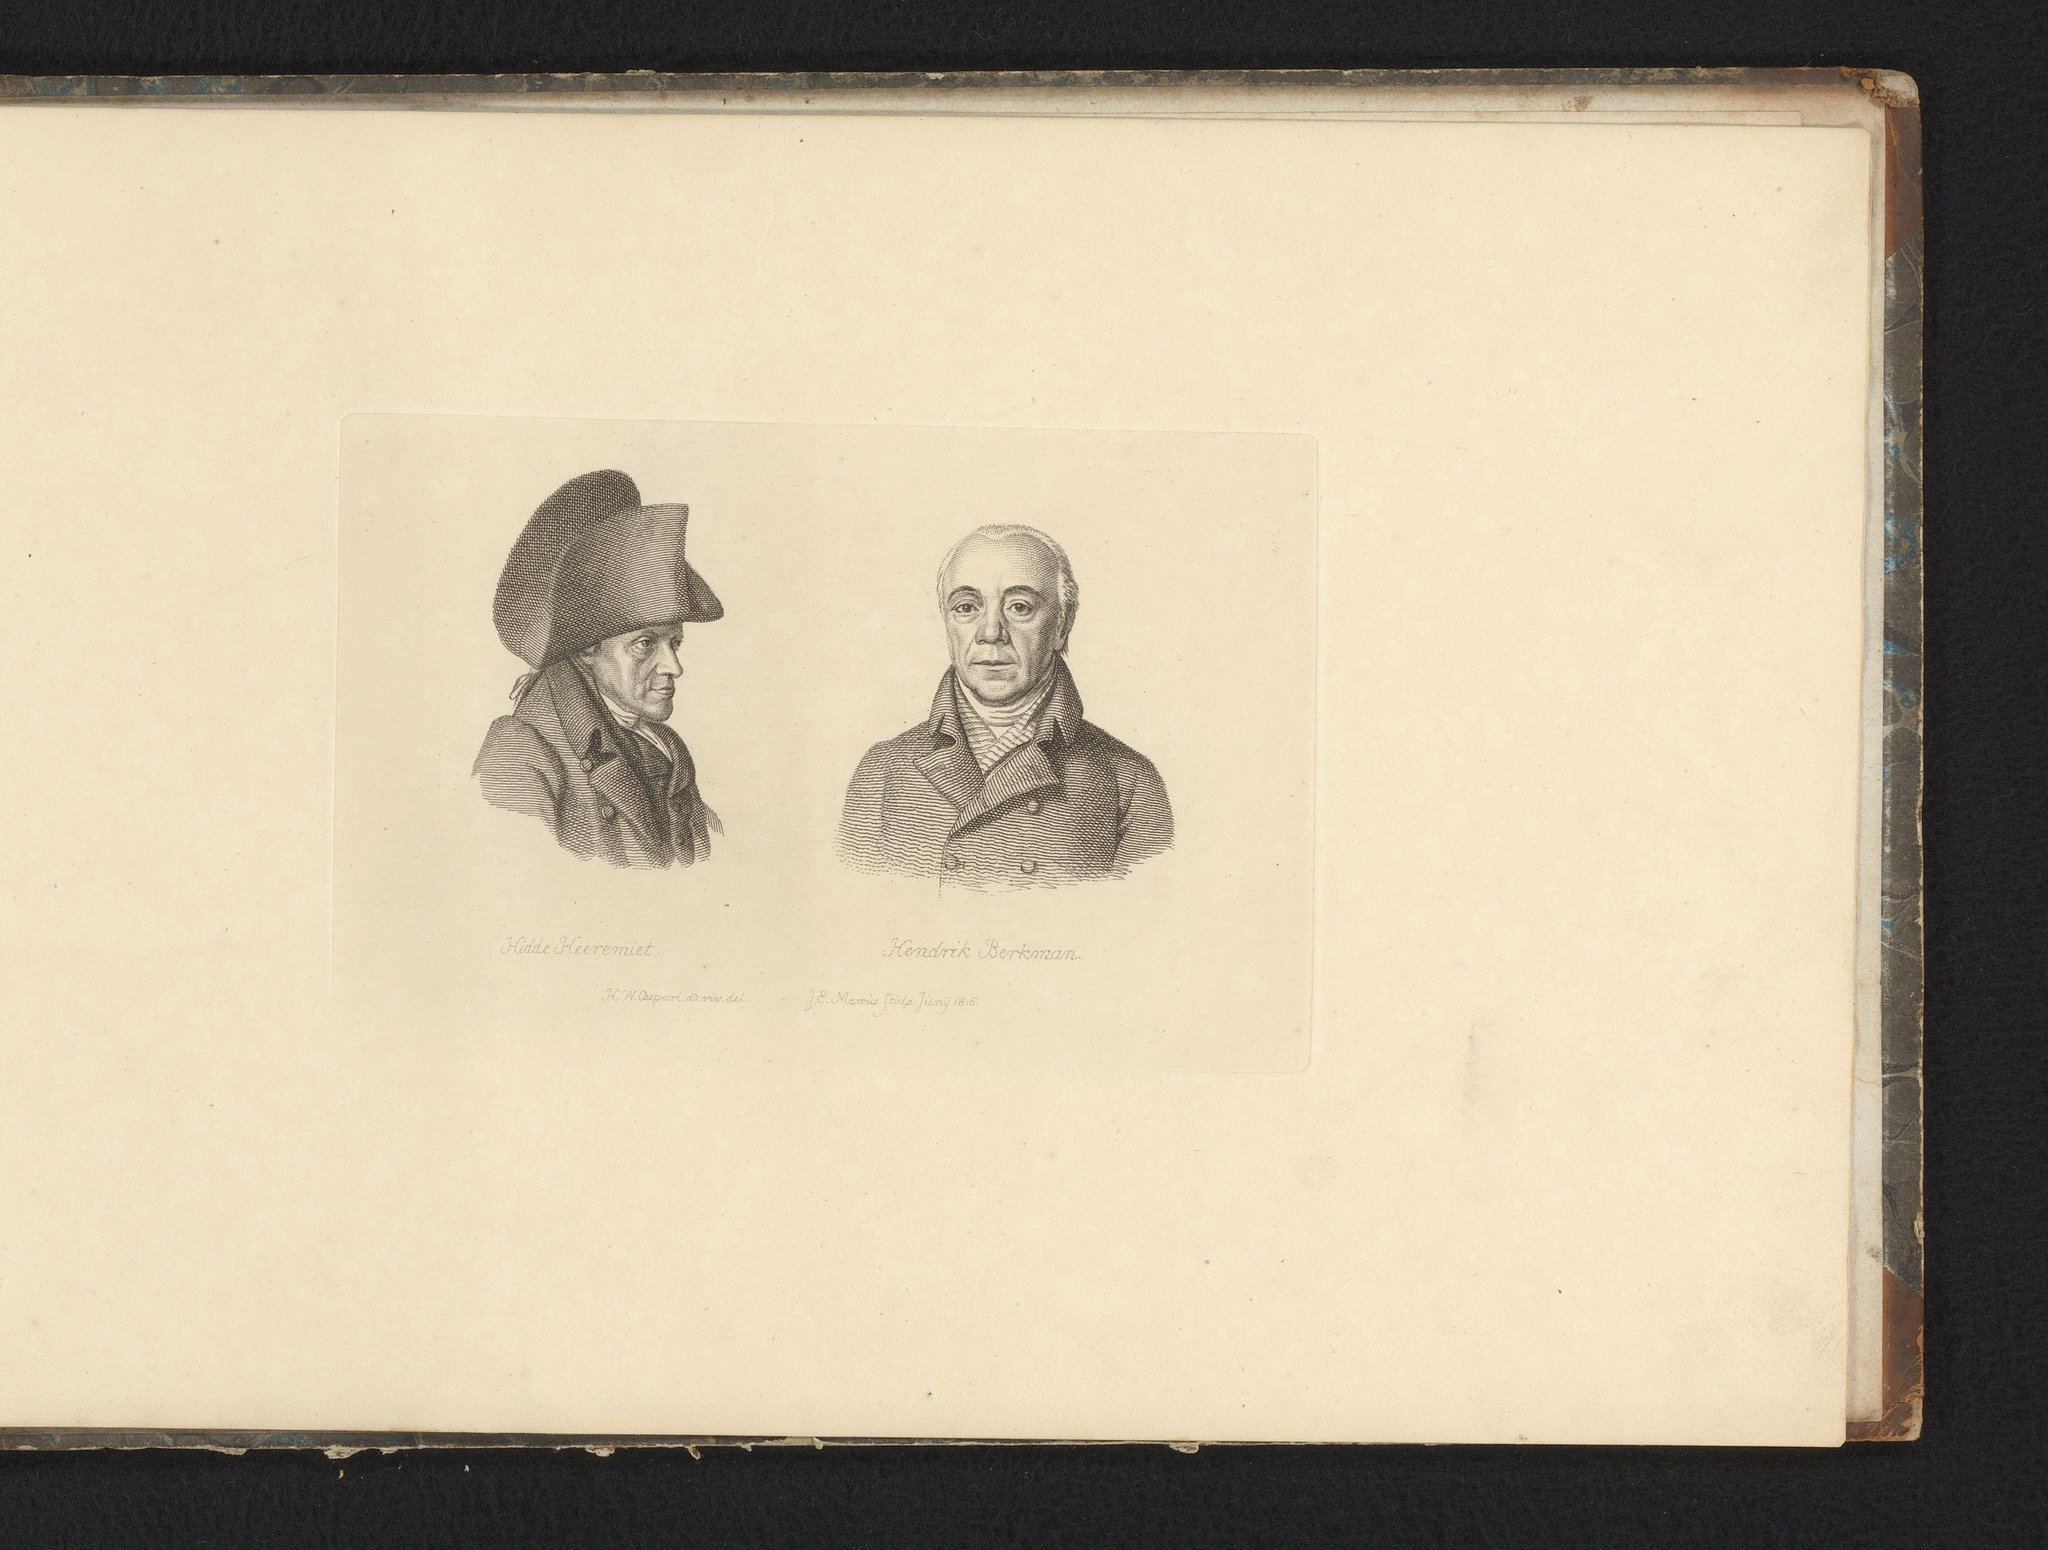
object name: album leaf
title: Portretten van Hidde Heeremiet en Hendrik Berkman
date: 1806-1816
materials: paper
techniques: etching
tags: amsterdam, historical persons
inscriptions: date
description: Deze prent maakt deel uit van een album.